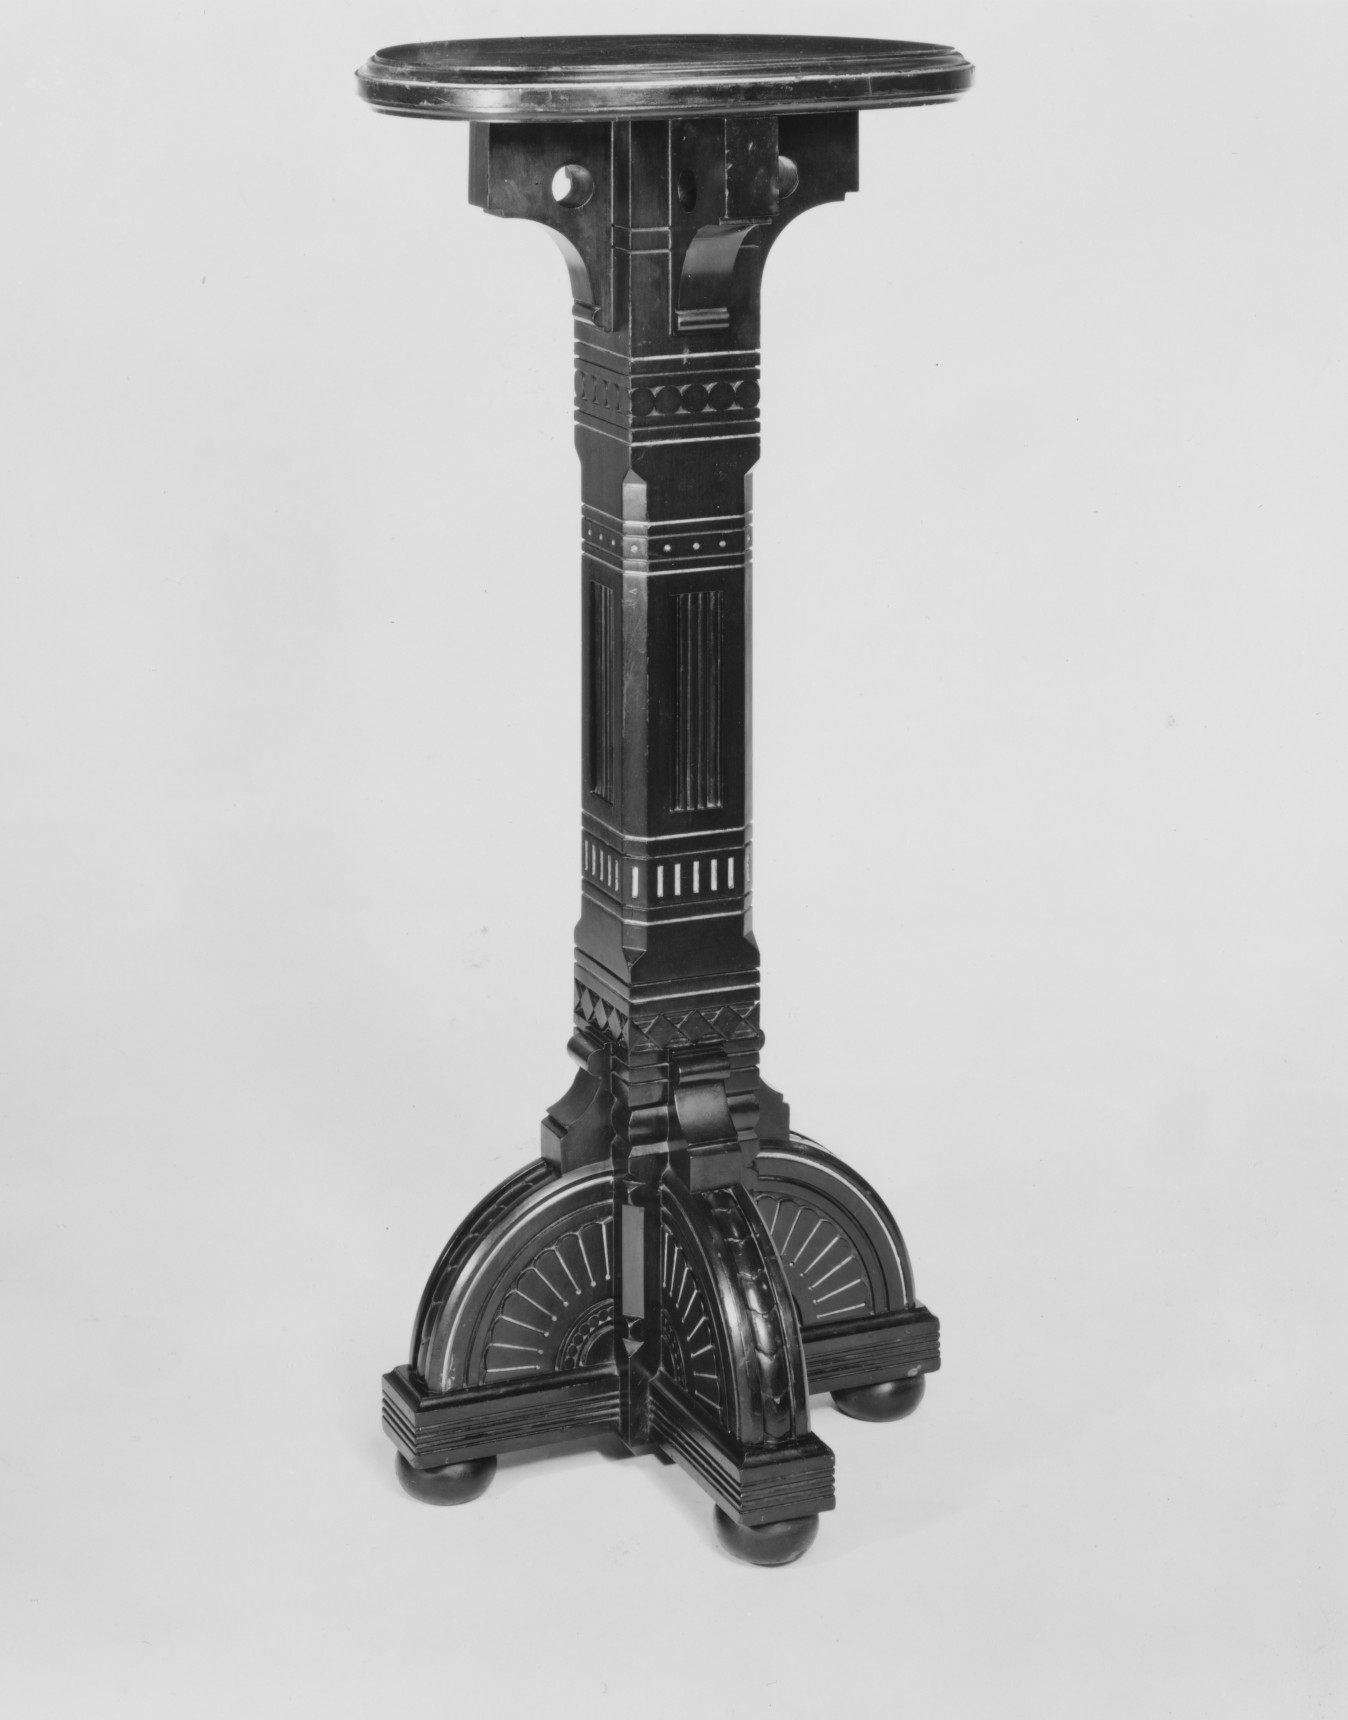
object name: pedestal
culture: american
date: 1880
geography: united states